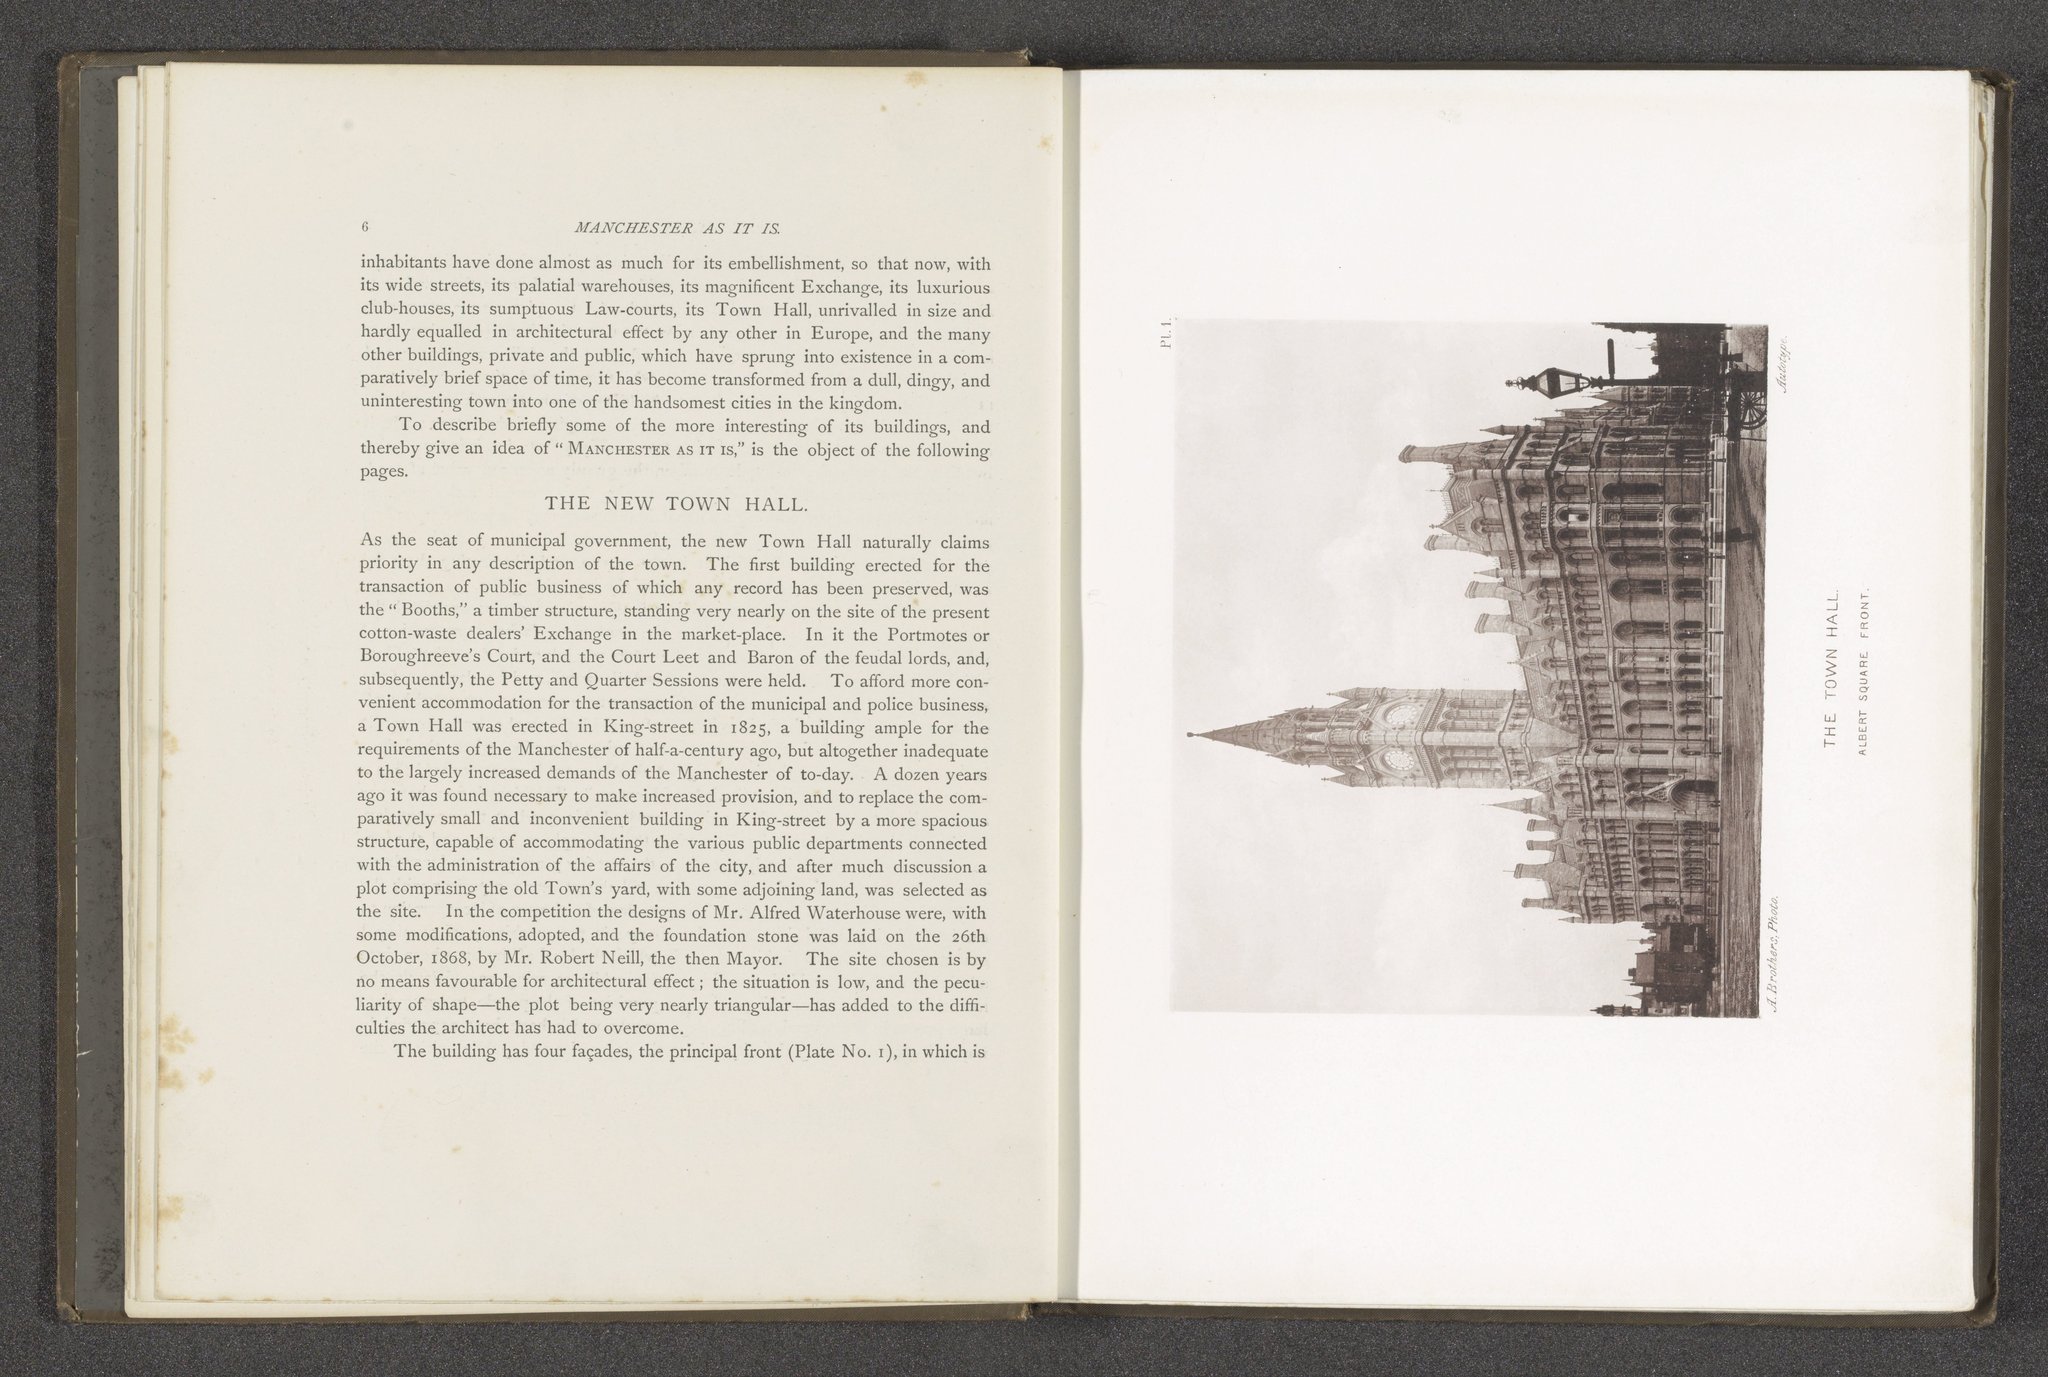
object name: photomechanical print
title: Gezicht op het stadhuis van Manchester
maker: Anonymous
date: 1868-1878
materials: paper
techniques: photograph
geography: manchester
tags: townhall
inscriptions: number: ‘Pl. 1.’